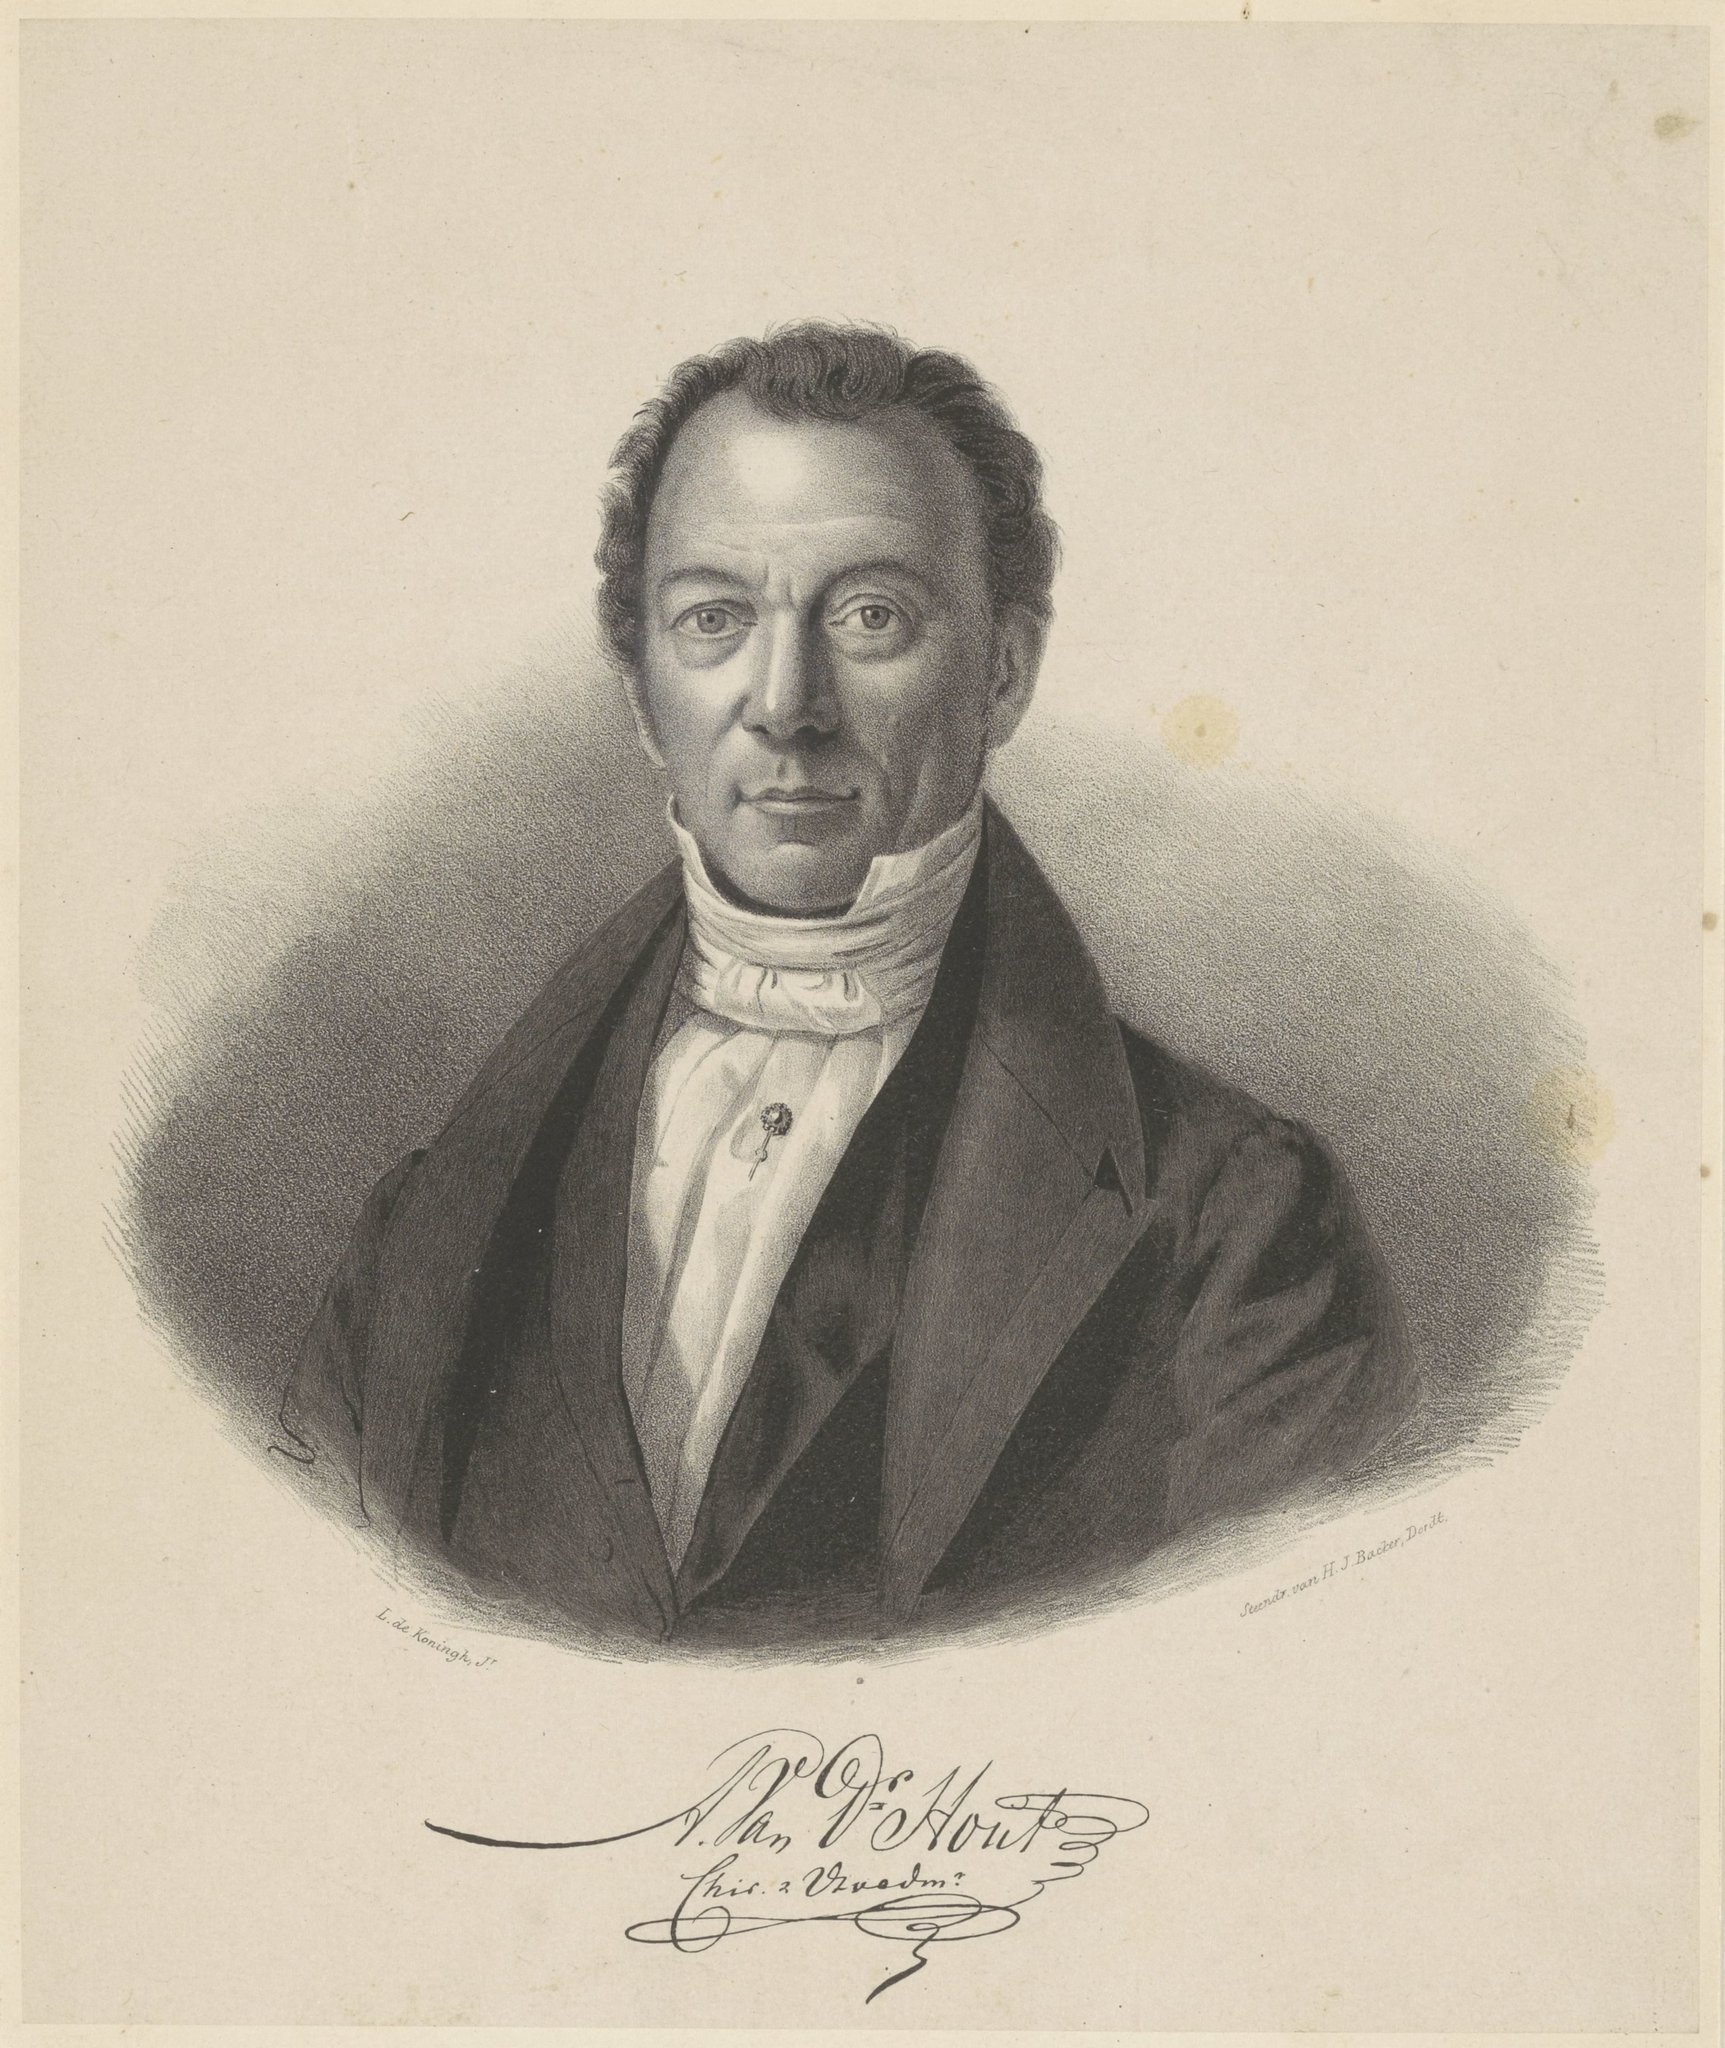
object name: print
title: Portret van dokter en verloskundige A. van der Hout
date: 1822-1845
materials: paper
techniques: lithograph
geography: dordrecht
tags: historical persons (+ (full) bust portrait), pin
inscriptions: collector's mark: Lugt 2228, collector's mark: Lugt 2760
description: De geportretteerde draagt een dasspeld. Onder het portret zijn signatuur.